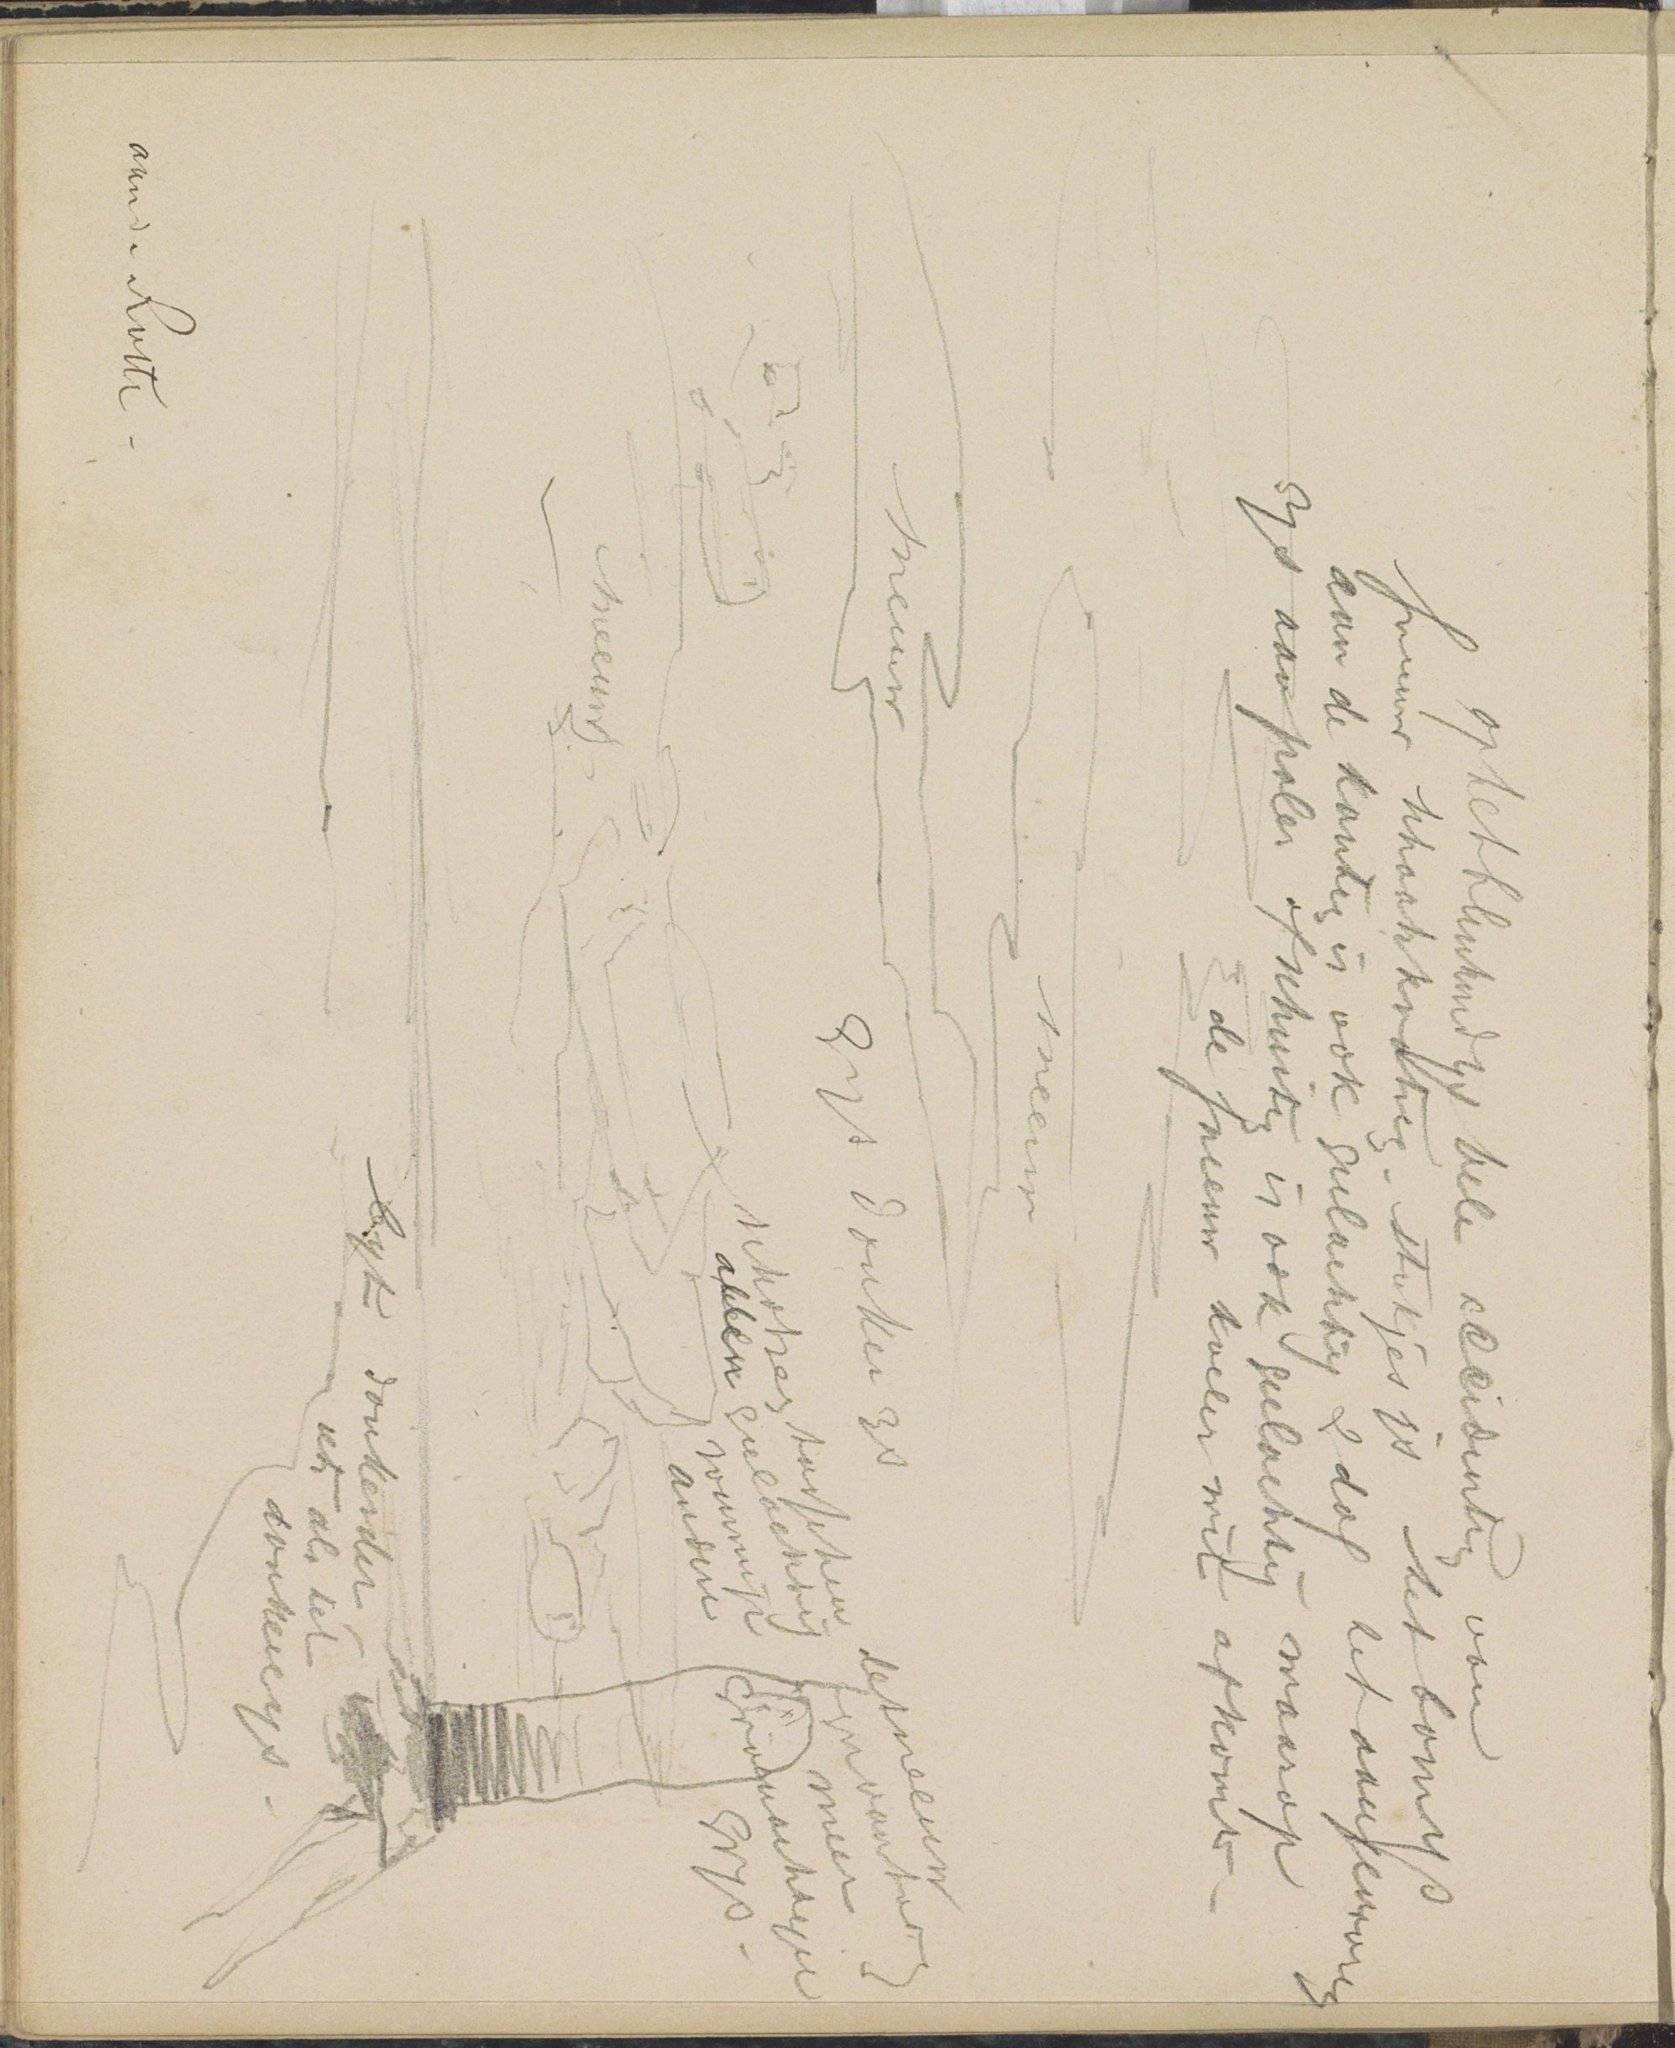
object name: sketchbook leaf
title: Aan de rivier de Rotte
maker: johannes tavenraat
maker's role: draughtsman, painter, print maker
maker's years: 1809-1881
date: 1841-1853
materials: paper, pencil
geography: south holland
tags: river, landscapes with waters, waterscapes, seascapes (in the temperate zone)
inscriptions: annotation: ‘aan de Rotte’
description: Blad 77 verso uit een schetsboek met 87 bladen.